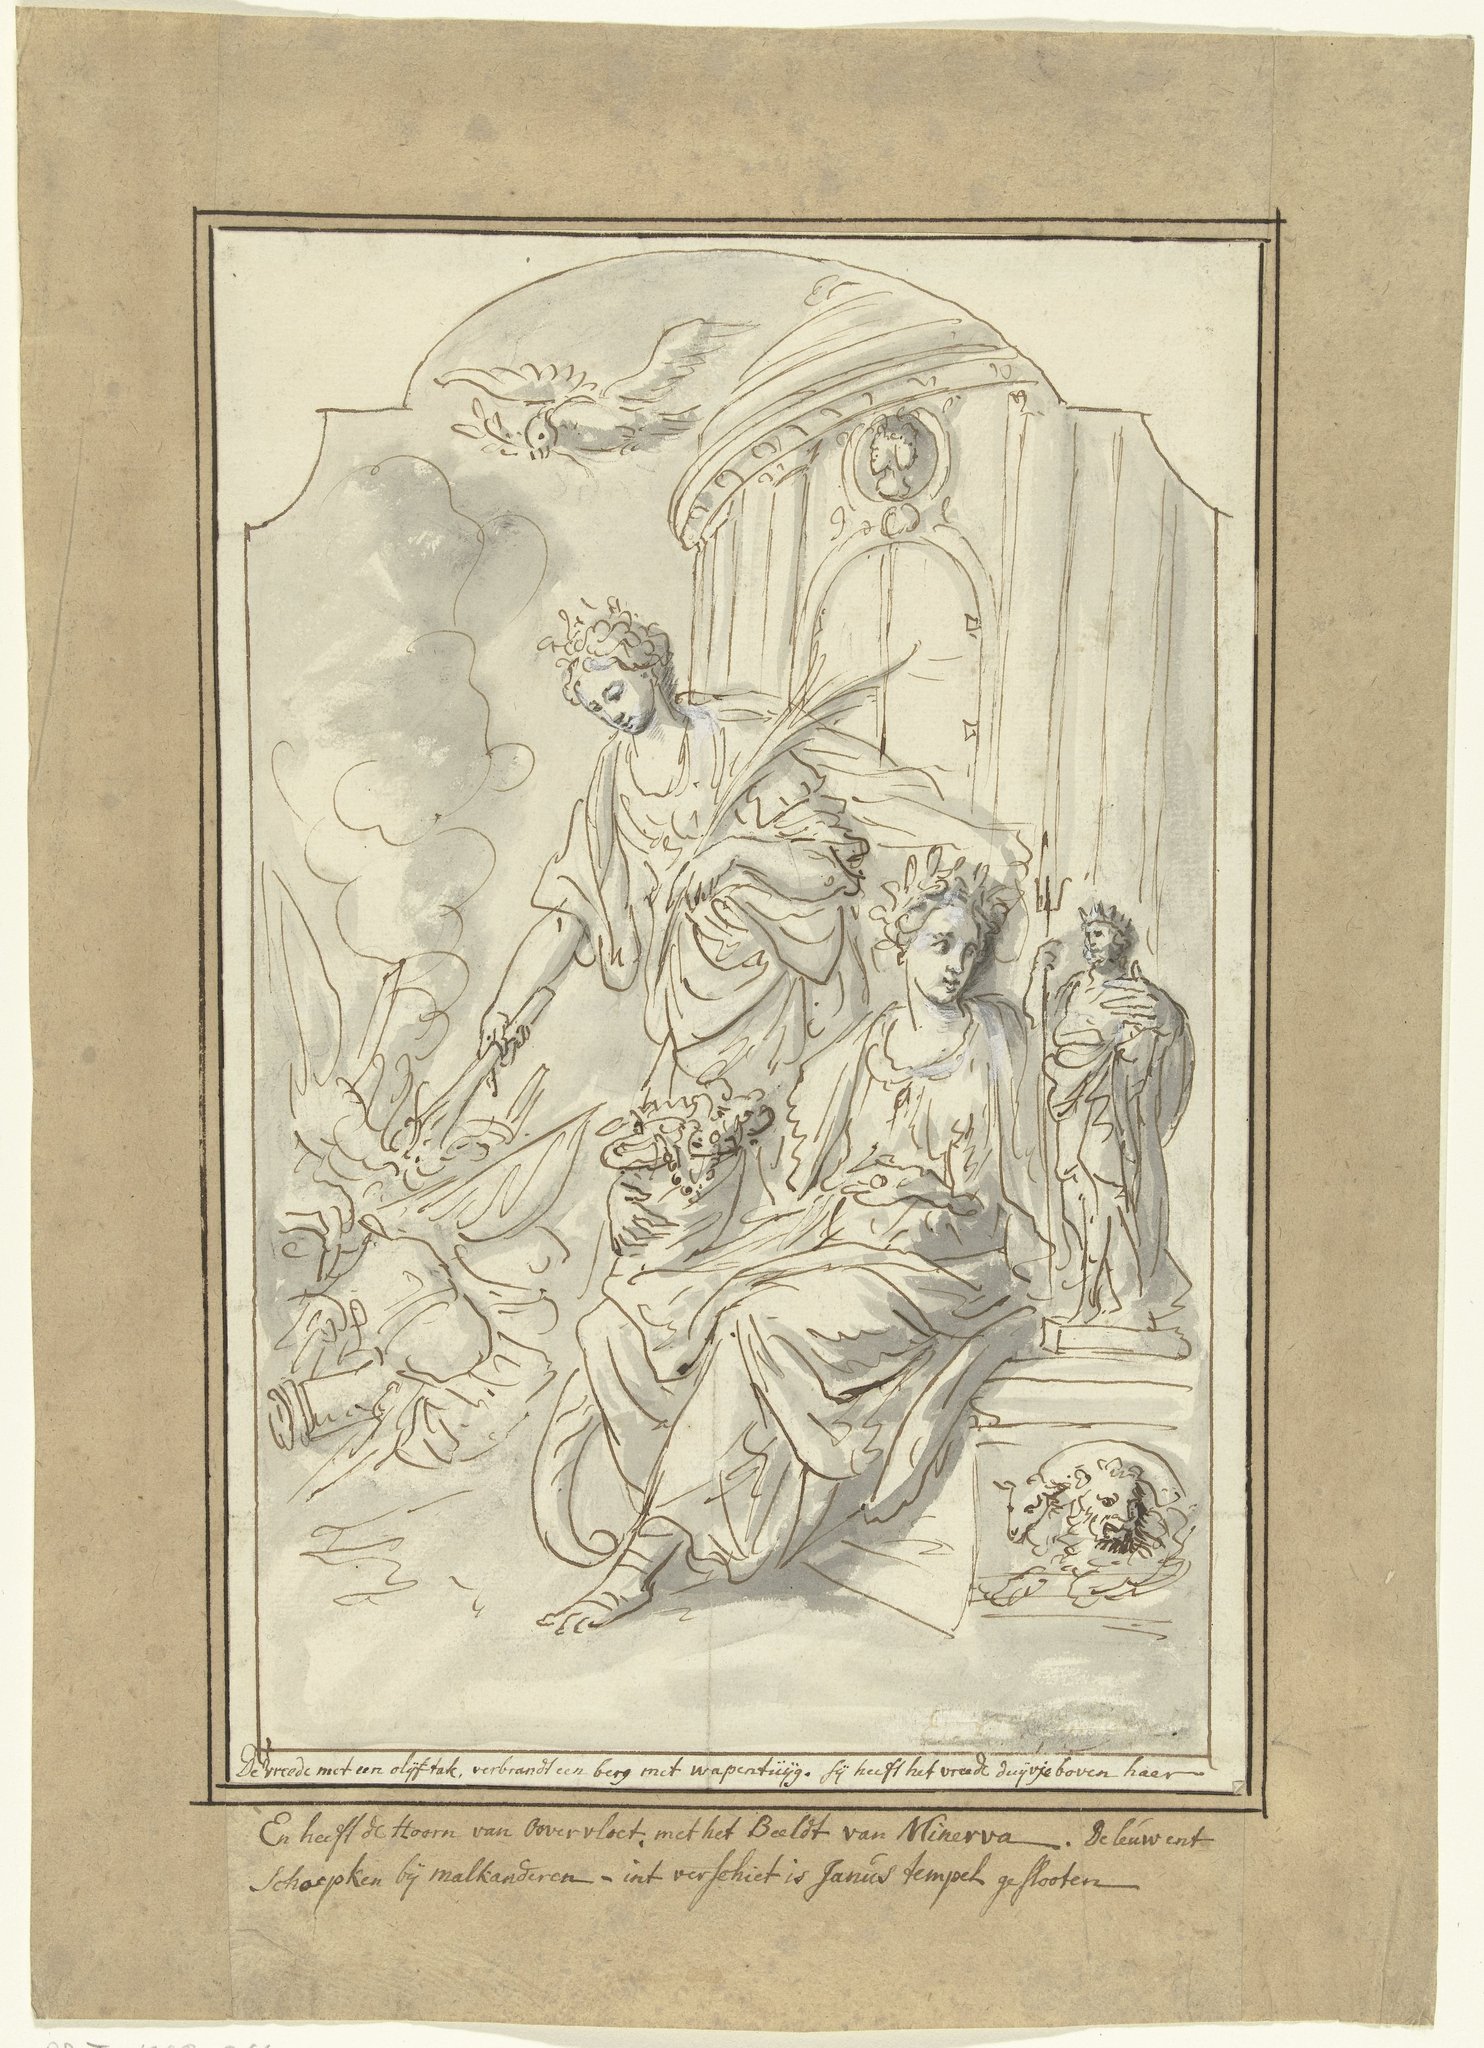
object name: design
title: Allegorie op de Vrede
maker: elias van nijmegen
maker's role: draughtsman, painter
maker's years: 1667-1755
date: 1677-1755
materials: paint, ink, paper, pencil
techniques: brush, pen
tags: symbols, allegories of peace, 'pax'; 'pace' (ripa)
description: Vrede verbrandt een stapel wapens; op de voorgrond zit Vrede met hoorn van overvloed en omarmt een beeldje van Minerva (?). Op de achtergrond een Janustempel met gesloten deuren. Ontwerp voor een schildering.